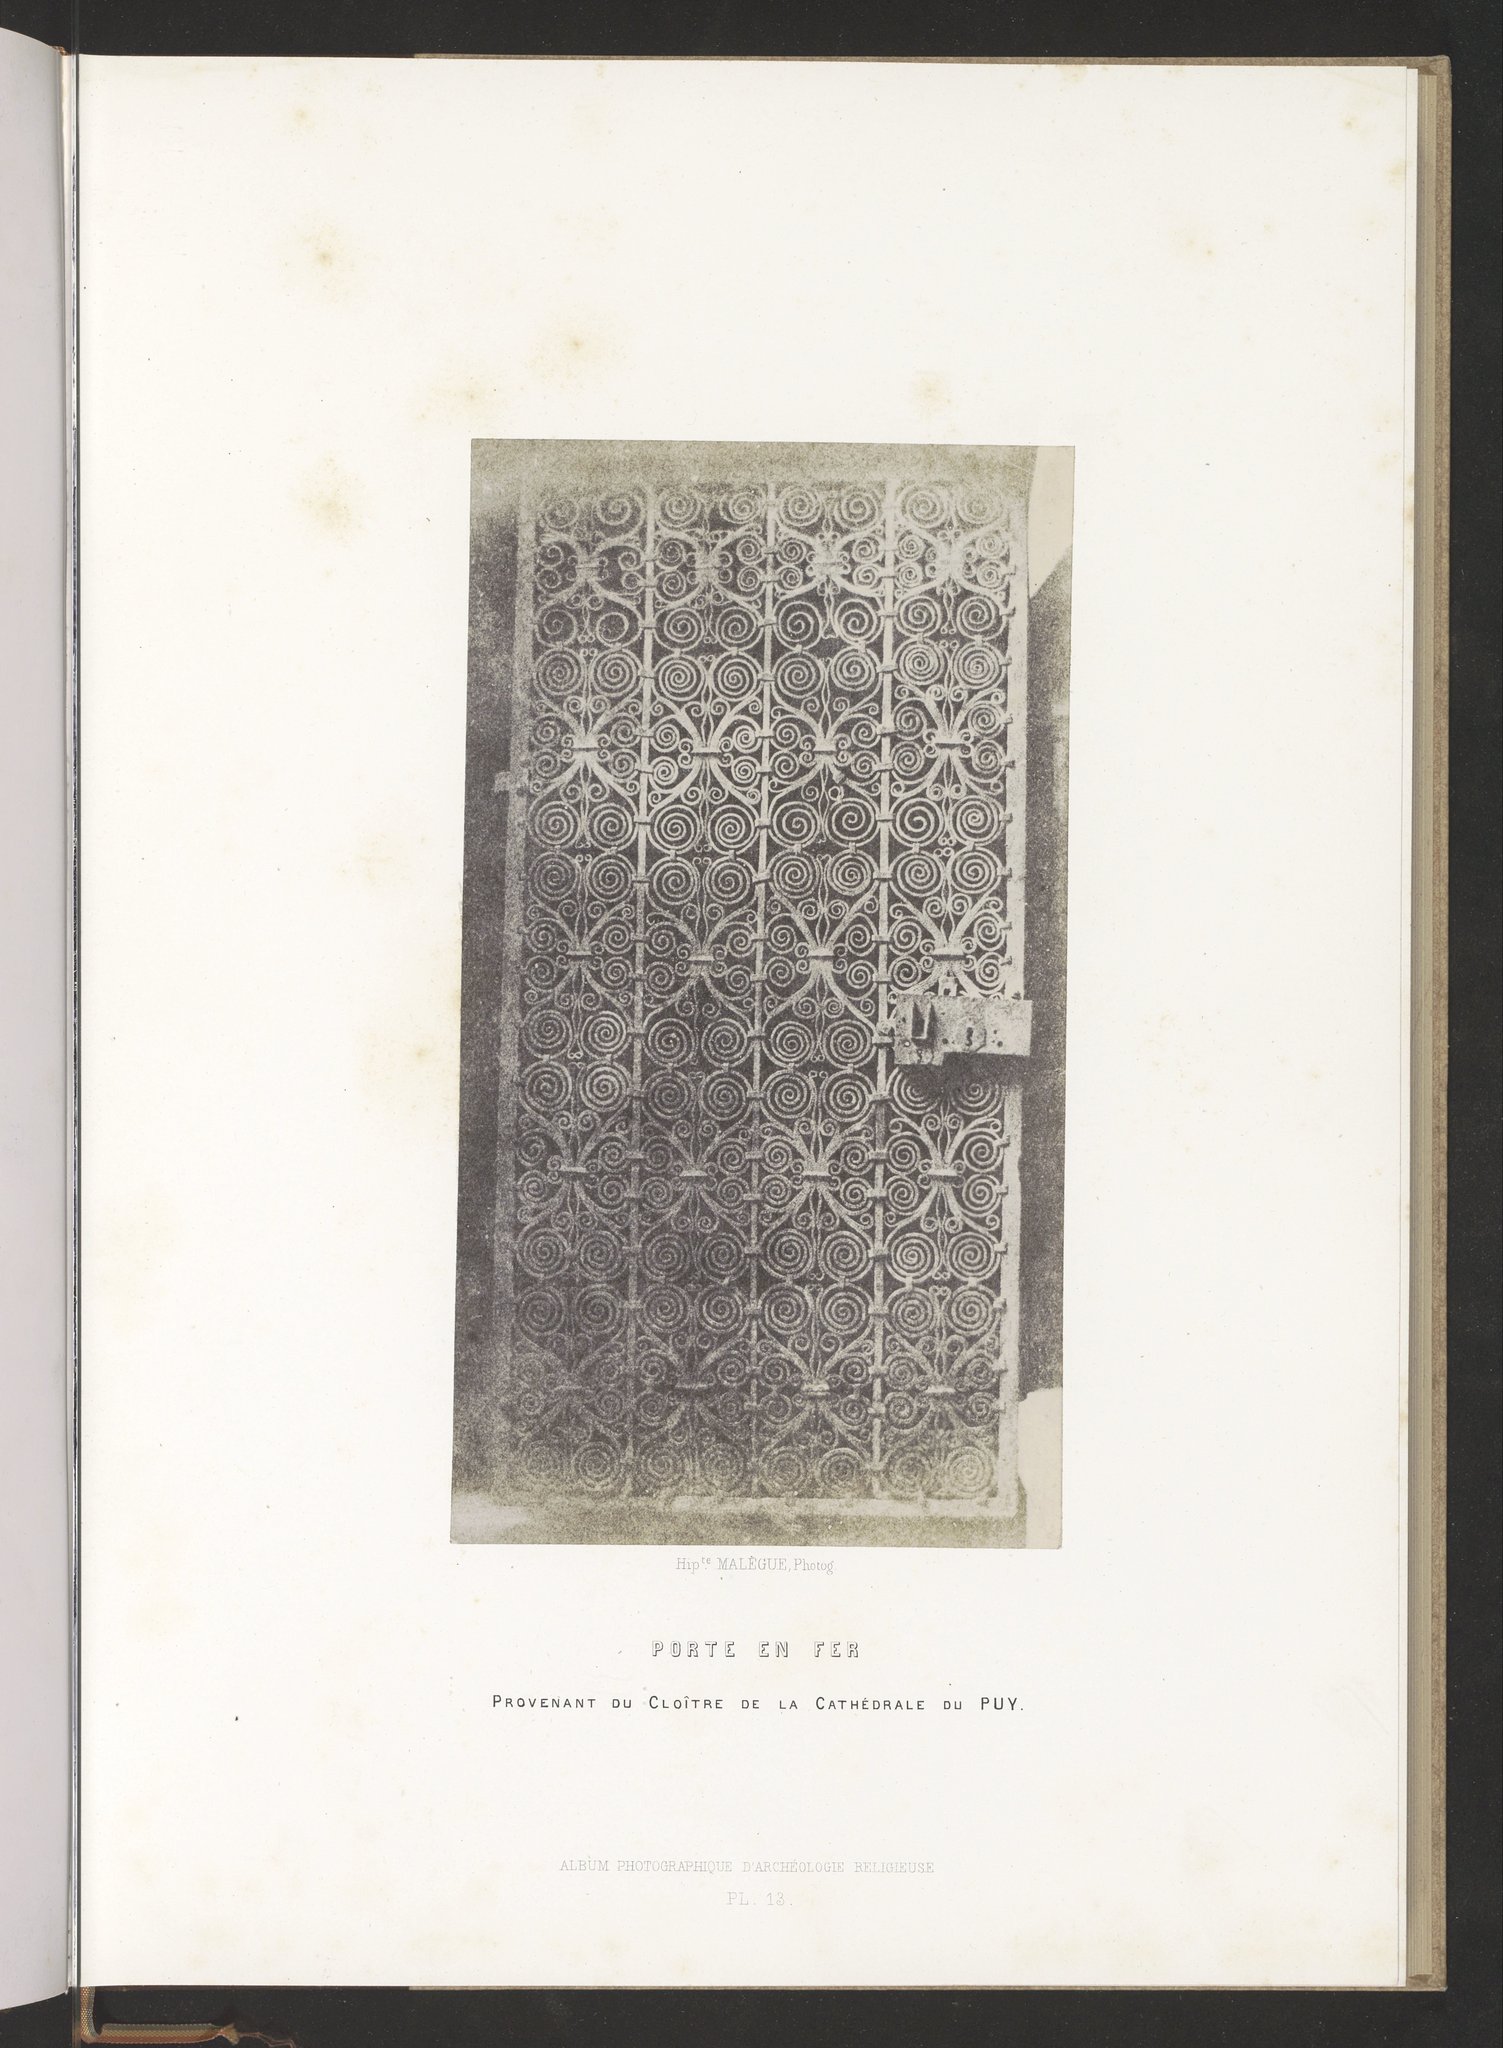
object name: photograph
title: Porte en fer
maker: hippolyte malègue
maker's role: archeoloog, fotograaf, schrijver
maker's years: 1825-1901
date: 1850-1857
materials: photographic support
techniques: salted paper print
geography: france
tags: ornament ~ circle and derived from circle, e.g.: guilloche, gate, entrance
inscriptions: inscription: ‘provenant du cloître de la Cathédrale du Puy.’, number: ‘PL. 13.’